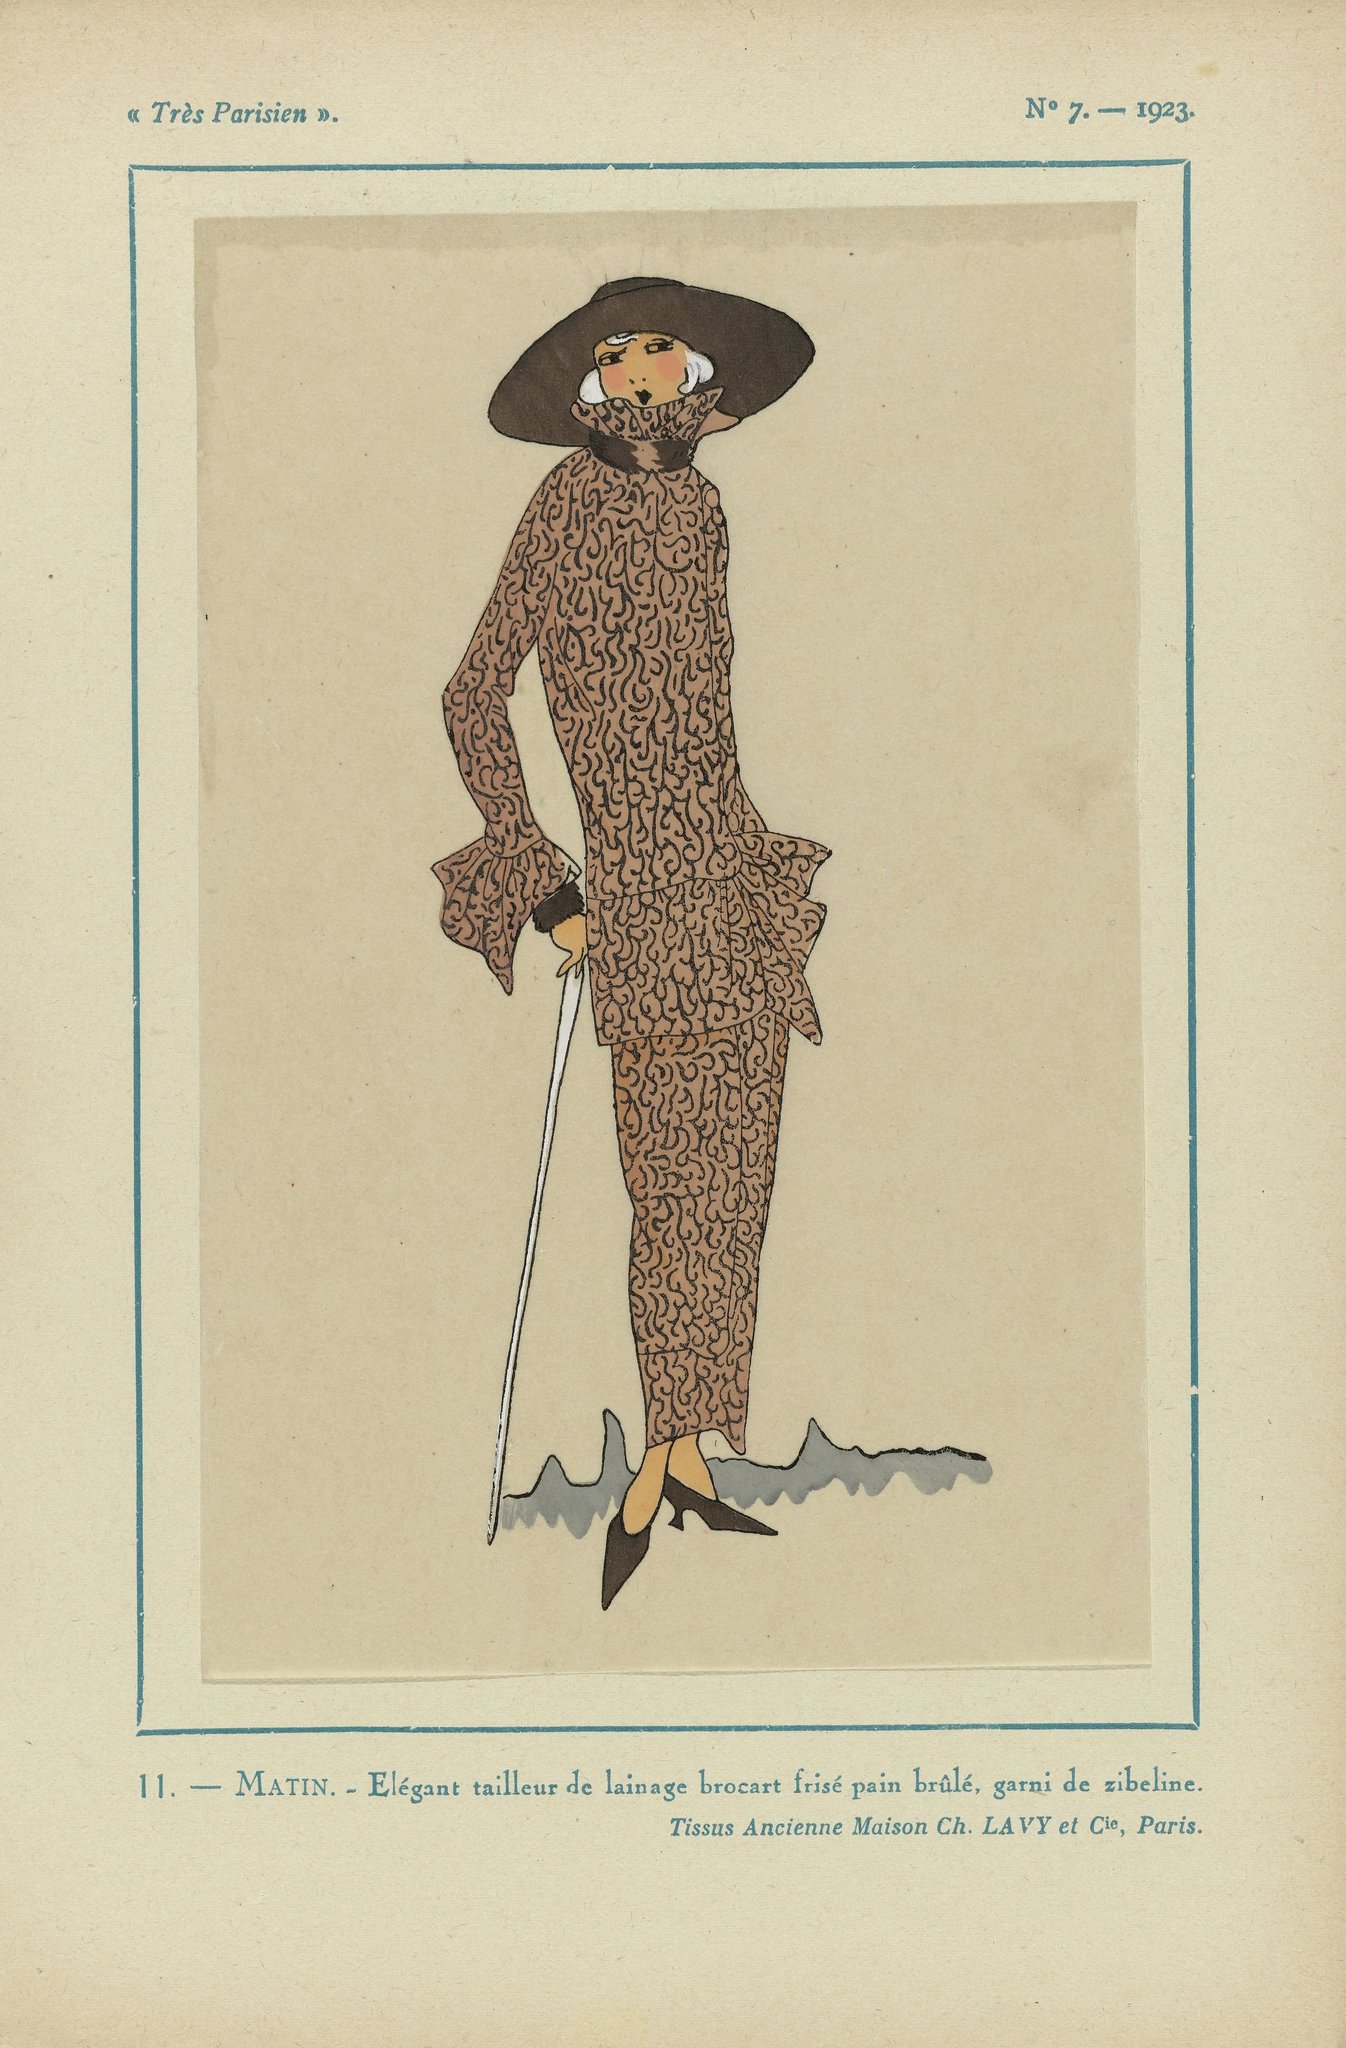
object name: fashion print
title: Très Parisien. La Mode, Le Chic, L’Elégance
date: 1923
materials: paper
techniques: hand coloring, letterpress printing, lithography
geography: paris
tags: walking-stick, staff, cane (+ women's clothes), ensembles of pieces of clothing (suit) (+ women's clothes), ornamental parts of clothing (+ fur used for clothes), coat (+ women's clothes), fashion plates, head-gear: hat (+ women's clothes), skirt (+ women's clothes)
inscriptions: title: ‘Très Parisien / No 7. - 1923’, caption: ‘11. - MATIN. - Elégant tailleur de lainage brocart frisé pain brûlé, garni de zibeline. Tissus Ancienne Maison Ch. LAVY et Cie, Paris.’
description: Très Parisien promoted itself as chic and elegant. Between 1920 and 1936 it presented creations by such couturiers as Chéruit, Premet, Philip et Gaston, and Lanvin. The young, svelte models are all ultra-modern, shown talking on the phone, smoking and playing tennis. The illustrations also show that over the course of the 1920s, skirt lengths had risen to just below the knee, before dropping back down to calf length in the 1930s. The small plates were printed on transparent paper using a stencilling technique known as en pochoir and then hand coloured; many of them are unsigned. The signature ‘Joujou’ belonged to Germaine Paule Joumard, who was the director of Très Parisien, as well as one of the magazine’s illustrators.